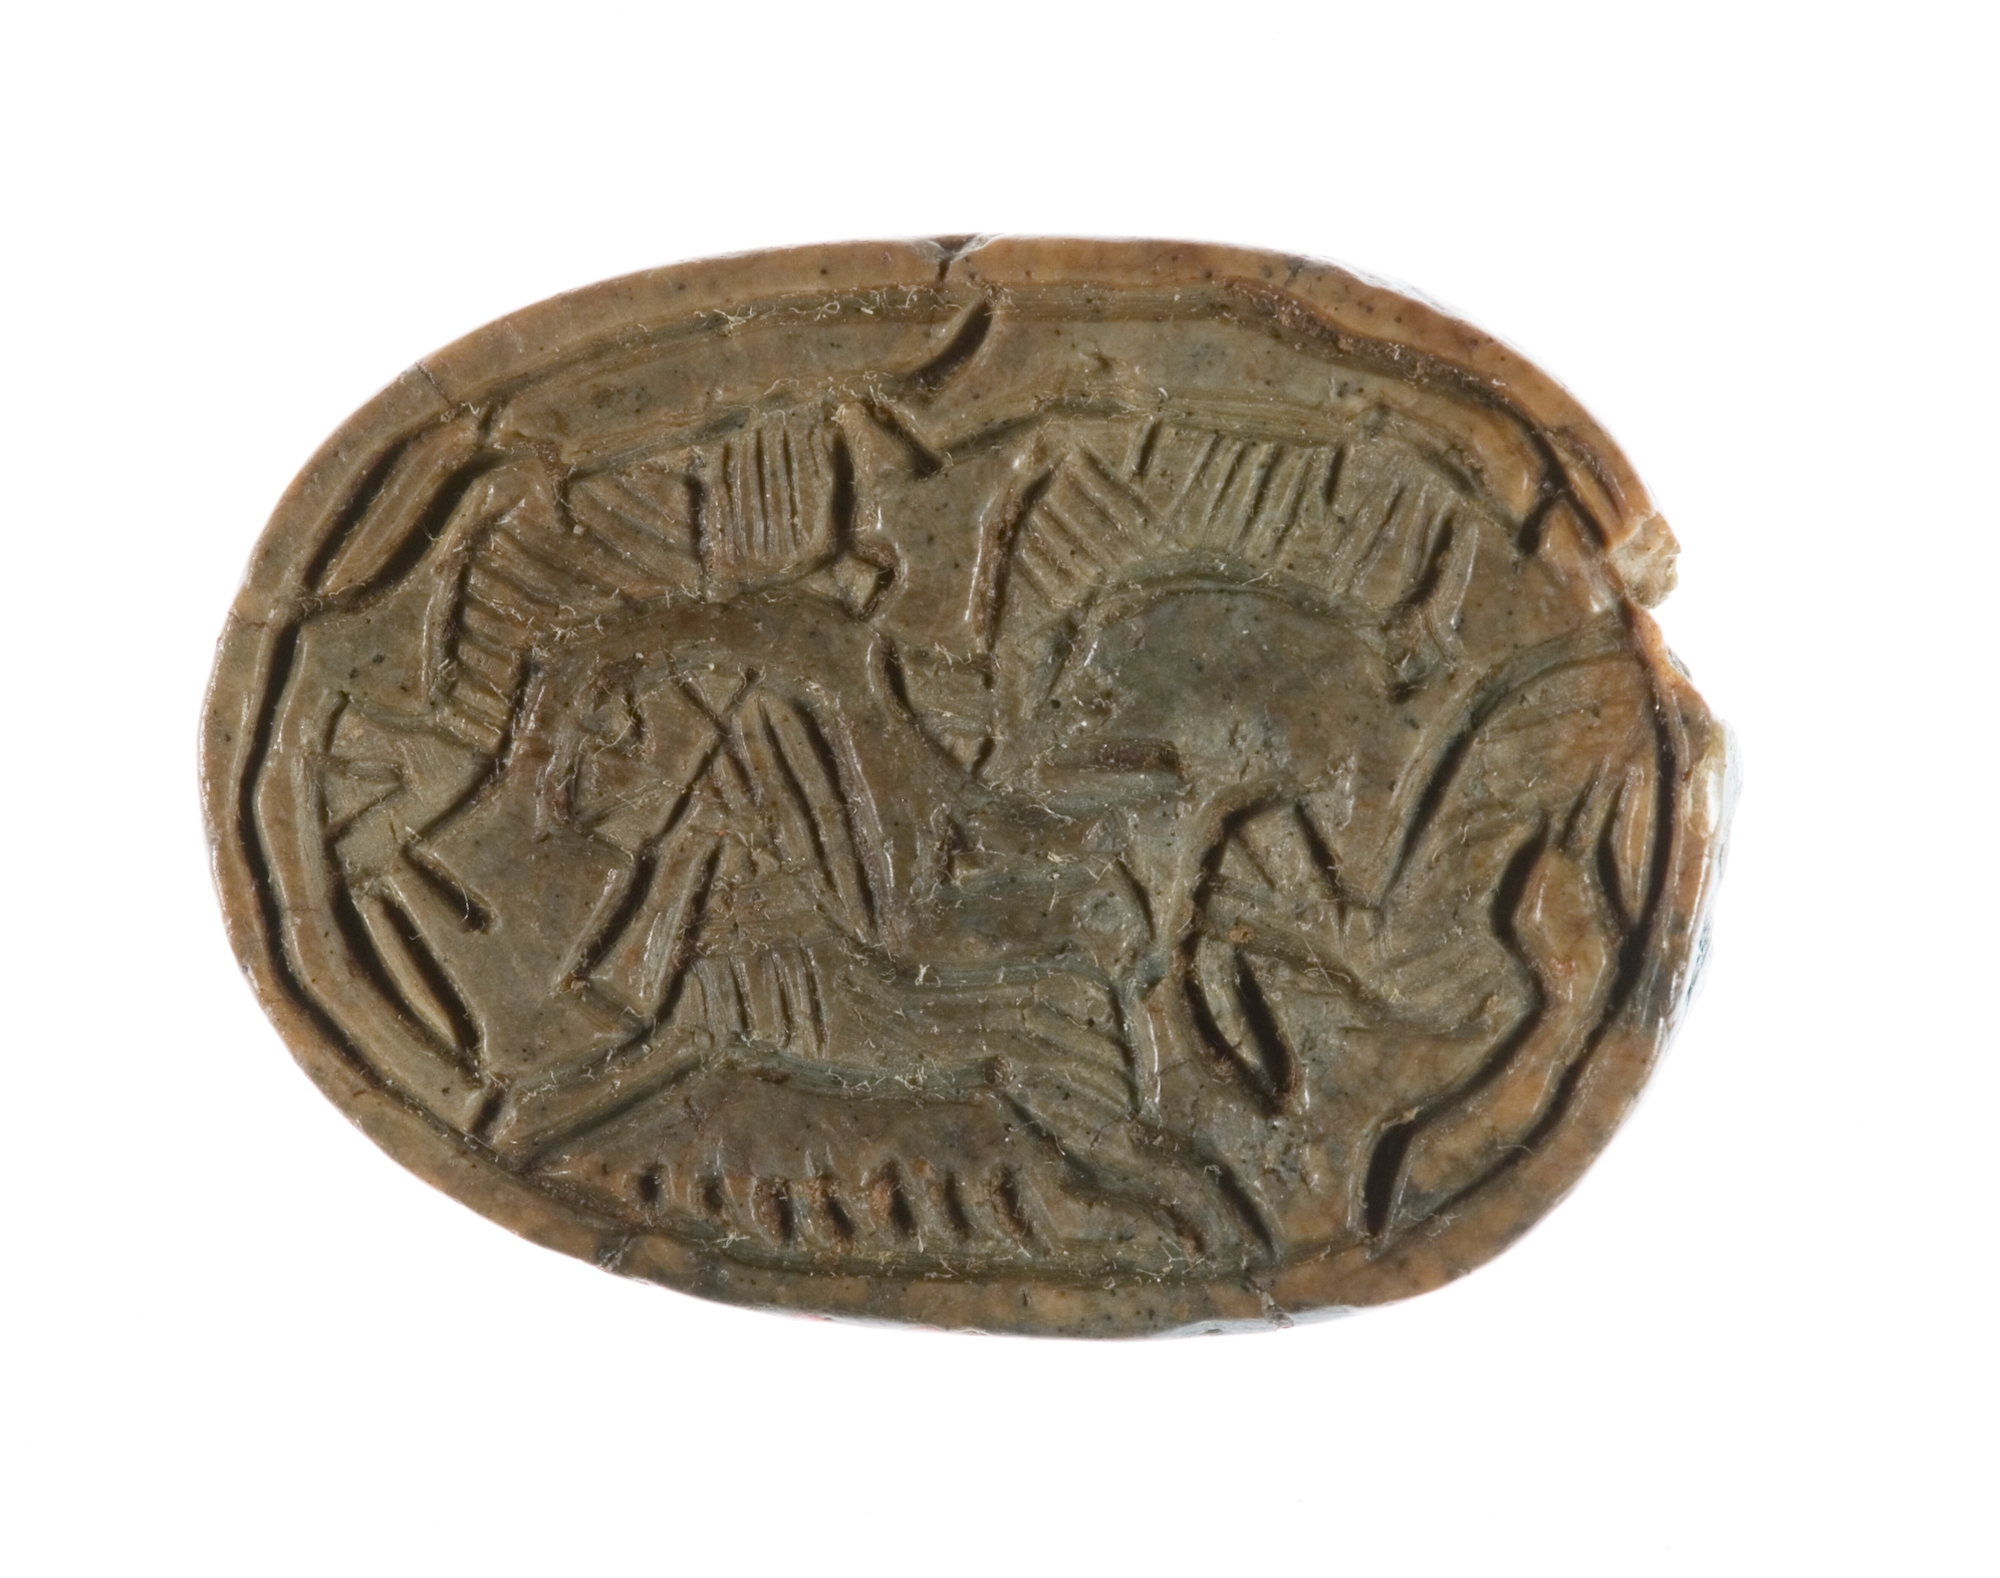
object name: scarab, lion, horned animal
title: Scarab with a Lion Hunting Horned Animals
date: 1600-1500 BCE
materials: stone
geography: egypt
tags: scarabs,lions